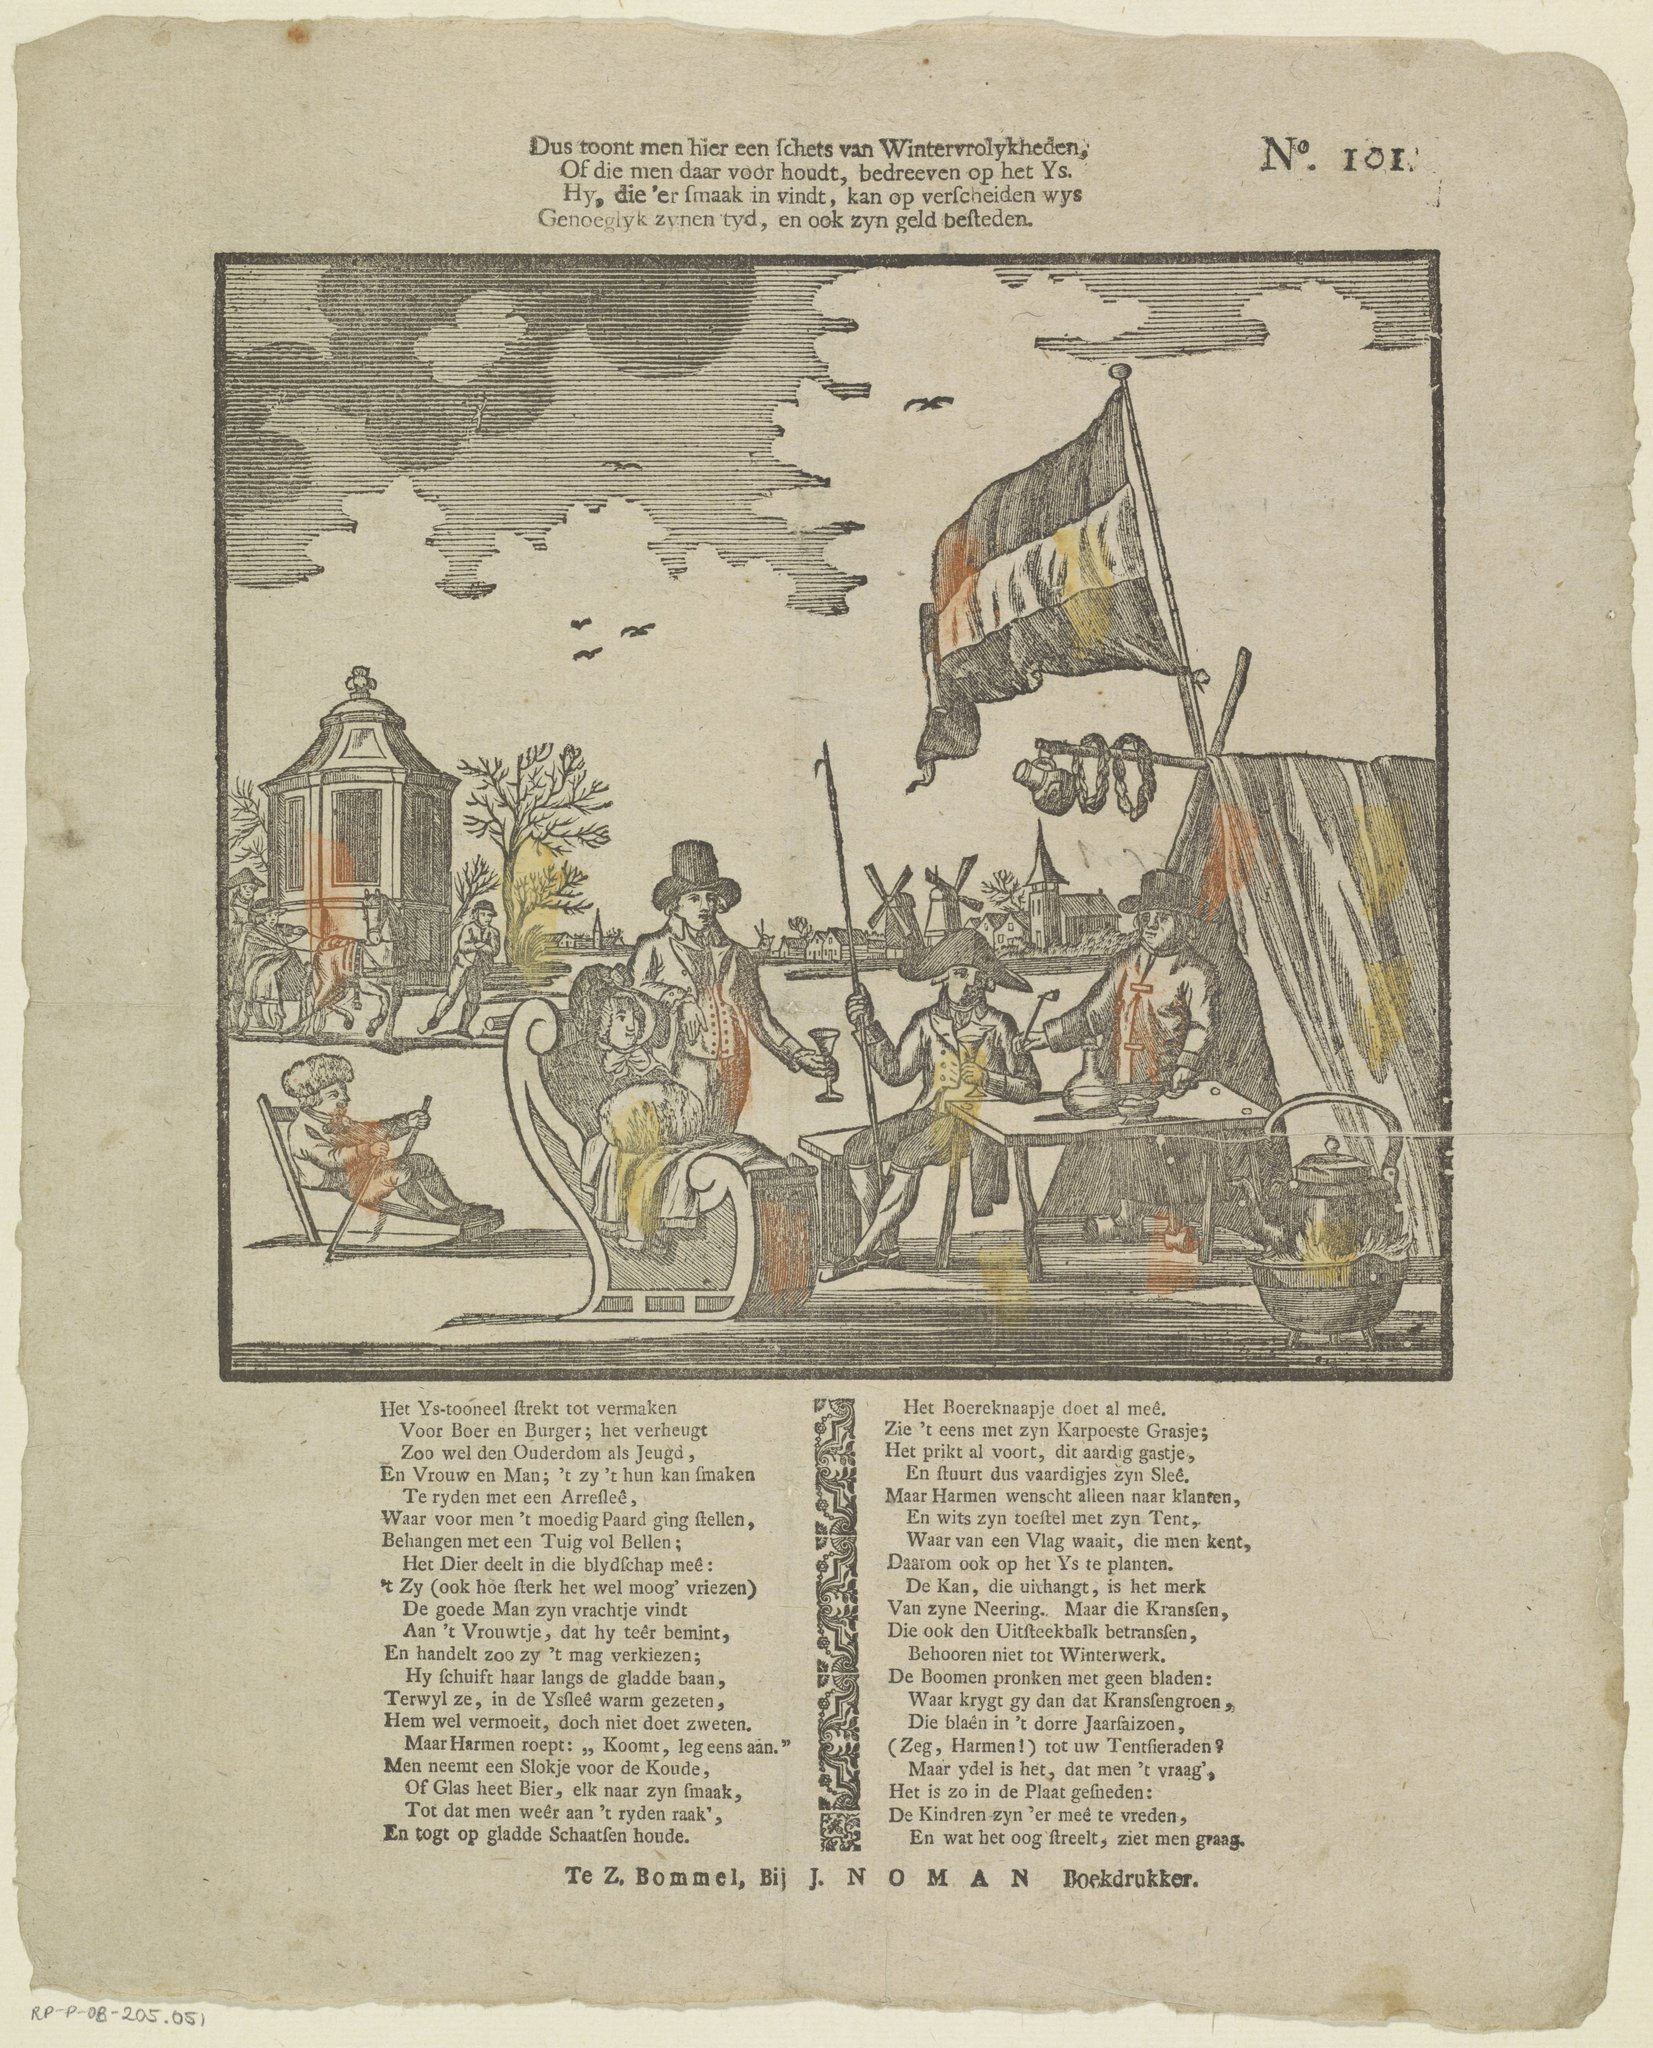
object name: print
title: Dus toont men hier een schets van wintervrolykheden, / Of die men daar voor houdt, bedreeven op het ys. / Hy, die 'er smaak in vindt, kan op verscheiden wys / Genoeglyk zynen tyd, en ook zyn geld besteden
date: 1806-1830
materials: paper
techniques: colour, letterpress printing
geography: netherlands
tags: winter sports, skates (winter sports), sledge, sleigh (winter sports)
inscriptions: collector's mark: Lugt 2760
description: Blad met een grote voorstelling van een winters tafereel, met mensen die sleeën en schaatsen en een verkoper van warme drank. Onder de afbeelding een vers in twee kolommen. Genummerd rechtsboven: No. 101.